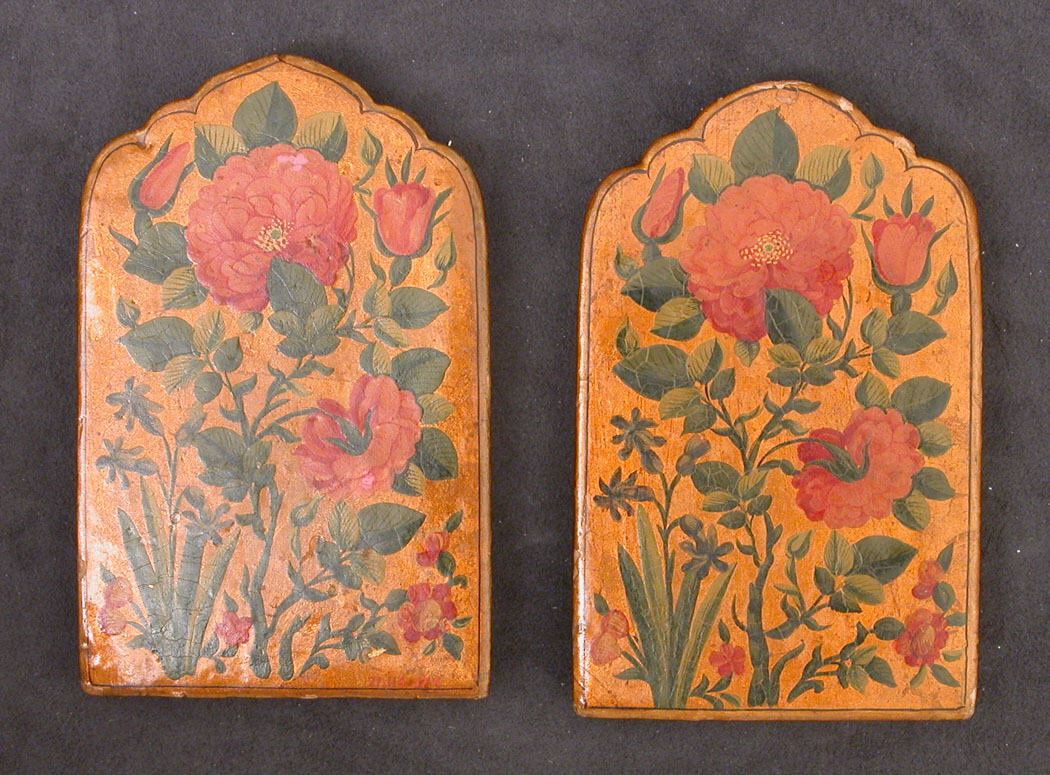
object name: mirror case cover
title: Mirror Case with Cover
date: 1801-1900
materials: board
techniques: lacquer, painting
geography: iran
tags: flowers